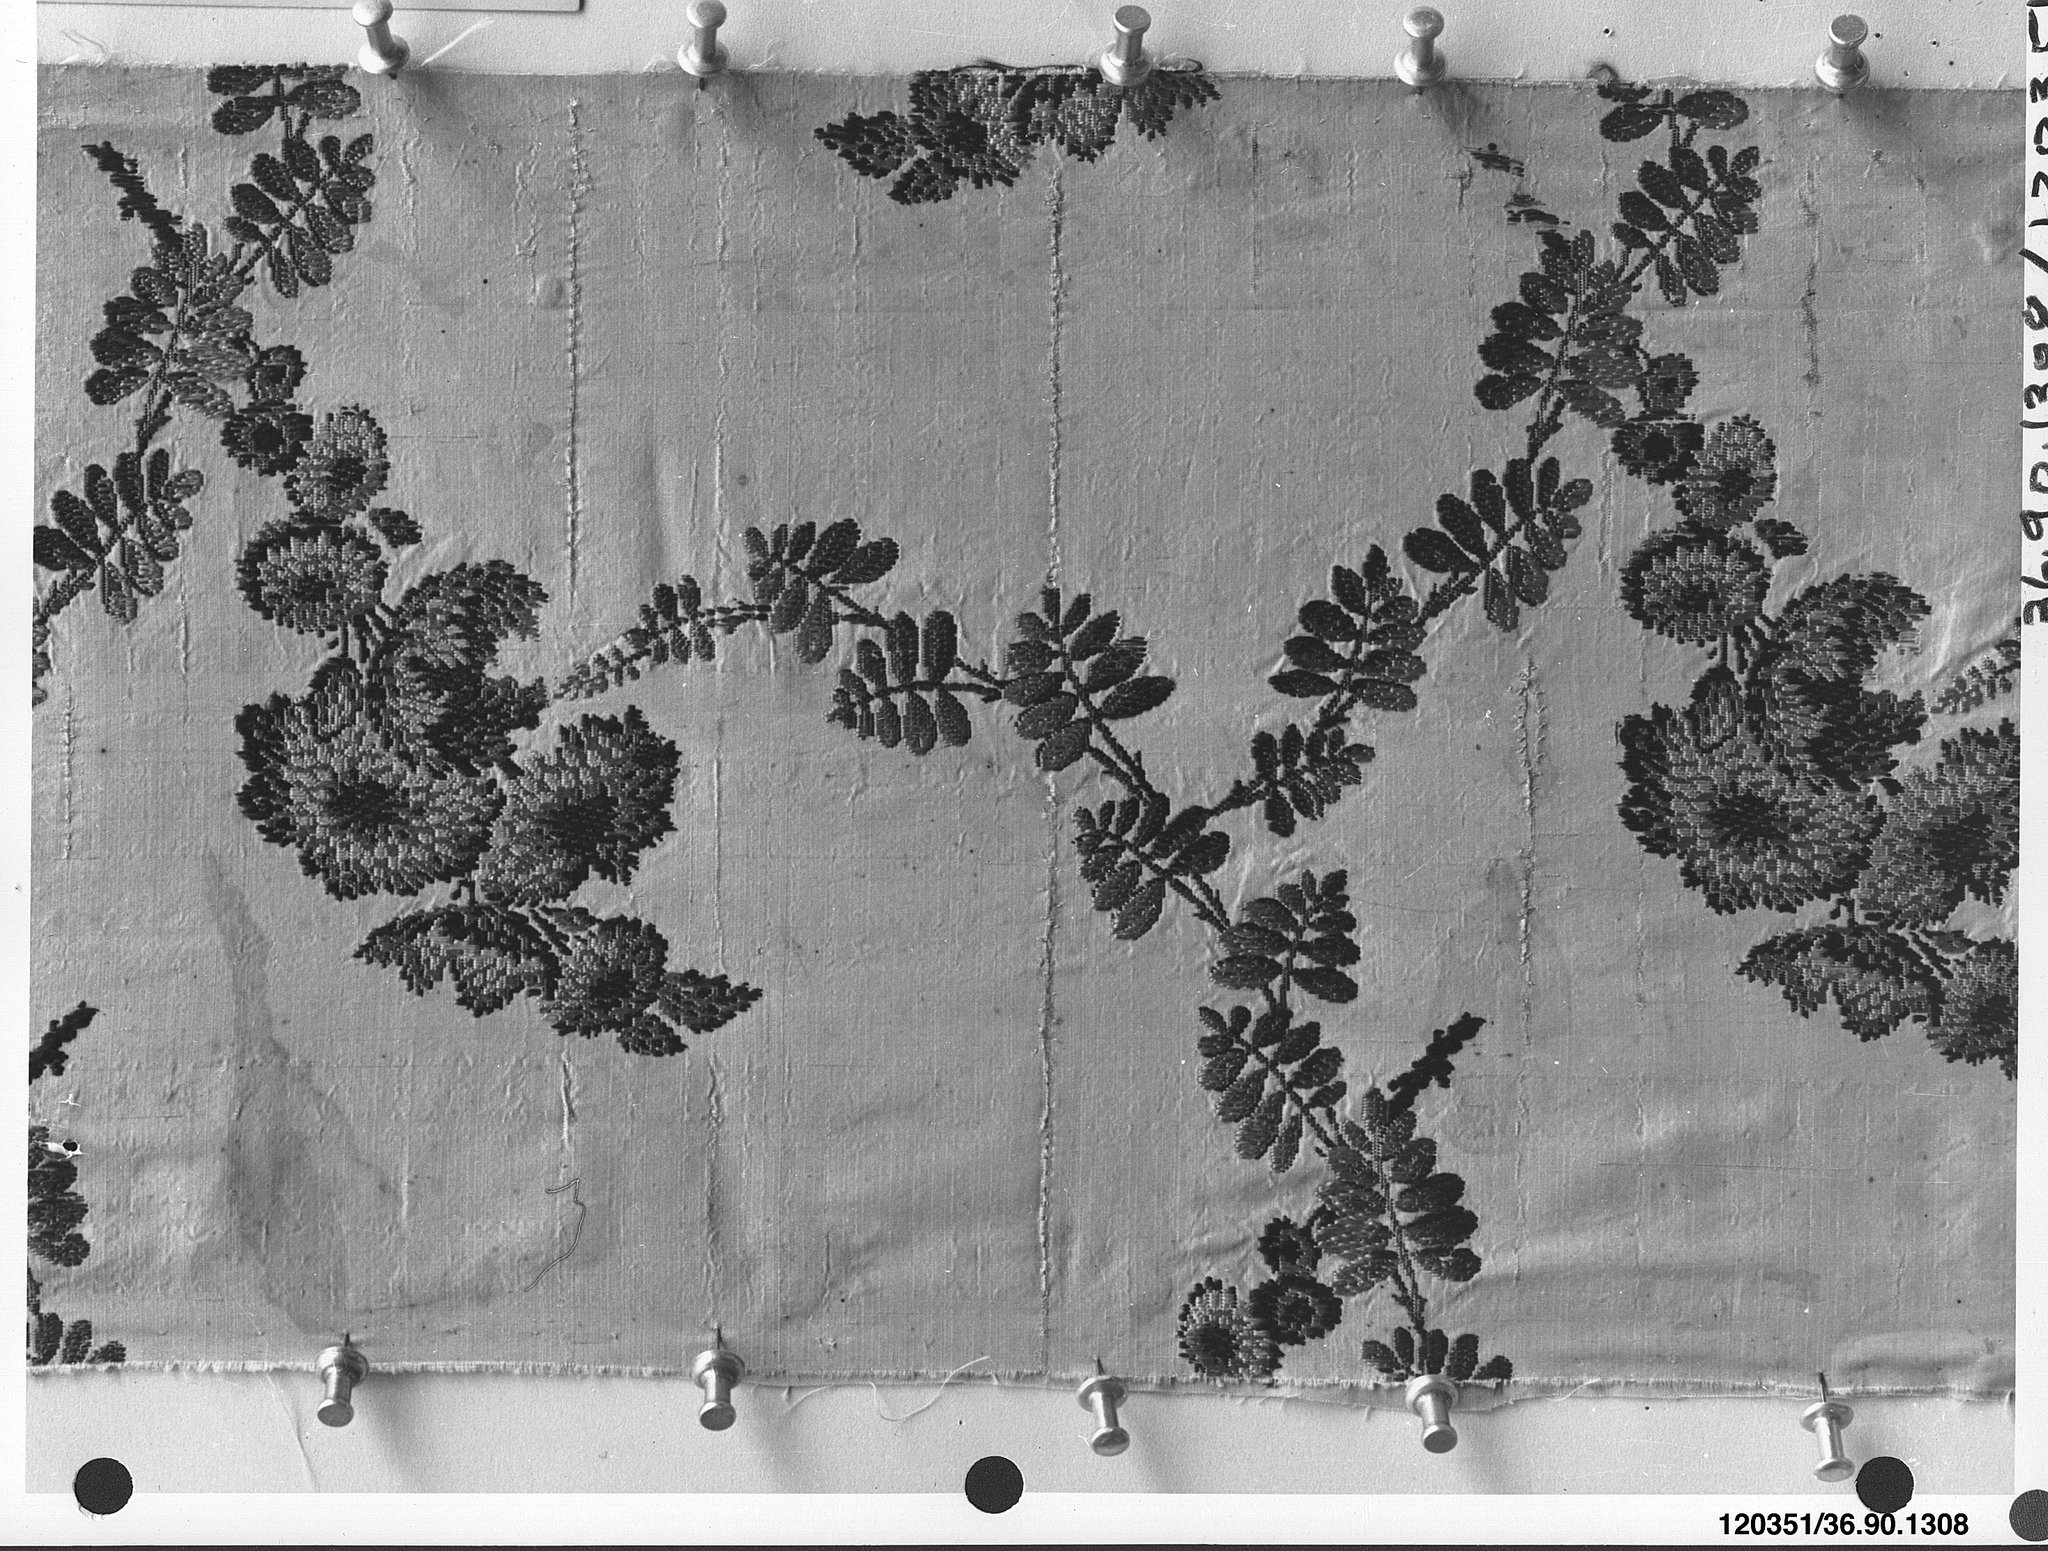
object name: piece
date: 1745-1750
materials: silk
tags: flowers,leaves